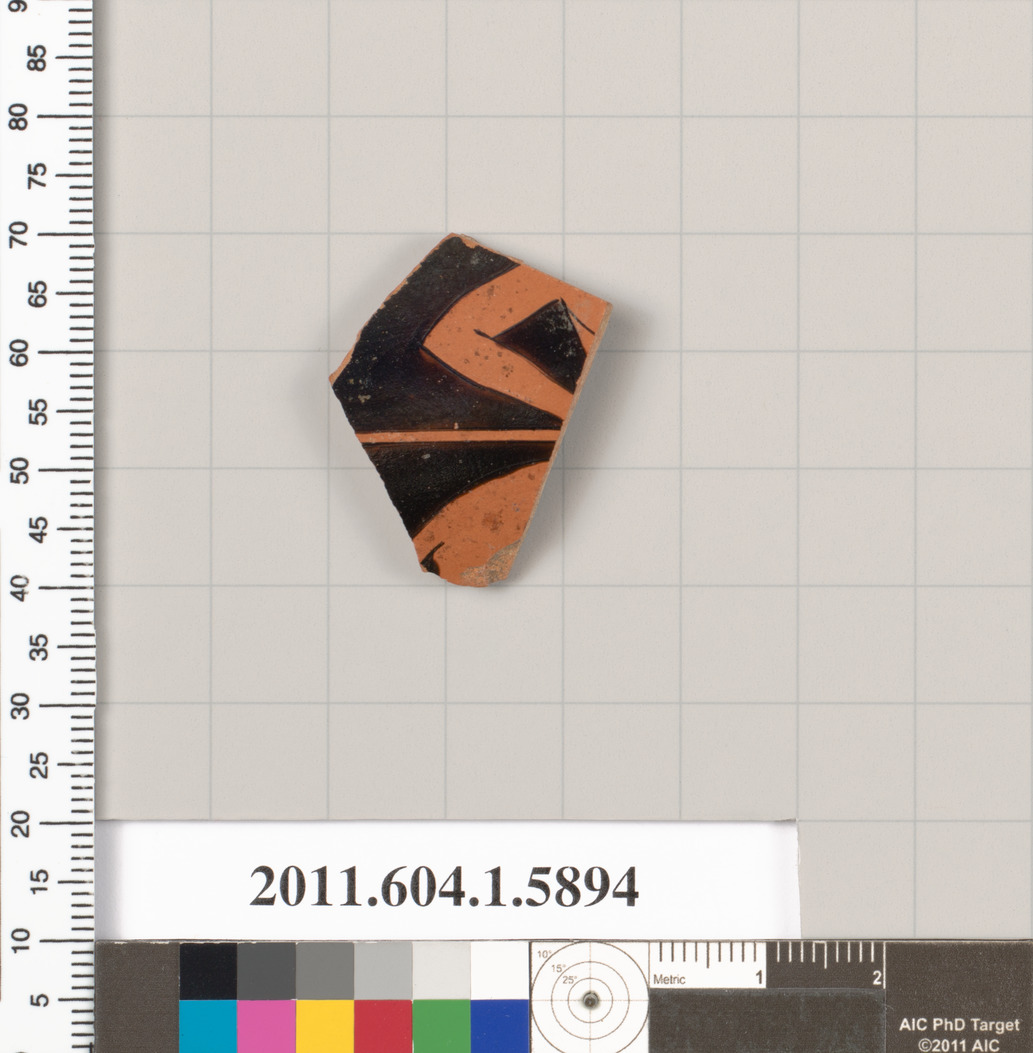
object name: kylix fragment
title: Terracotta fragment of a kylix (drinking cup)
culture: greek, attic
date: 520-510 BCE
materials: terracotta